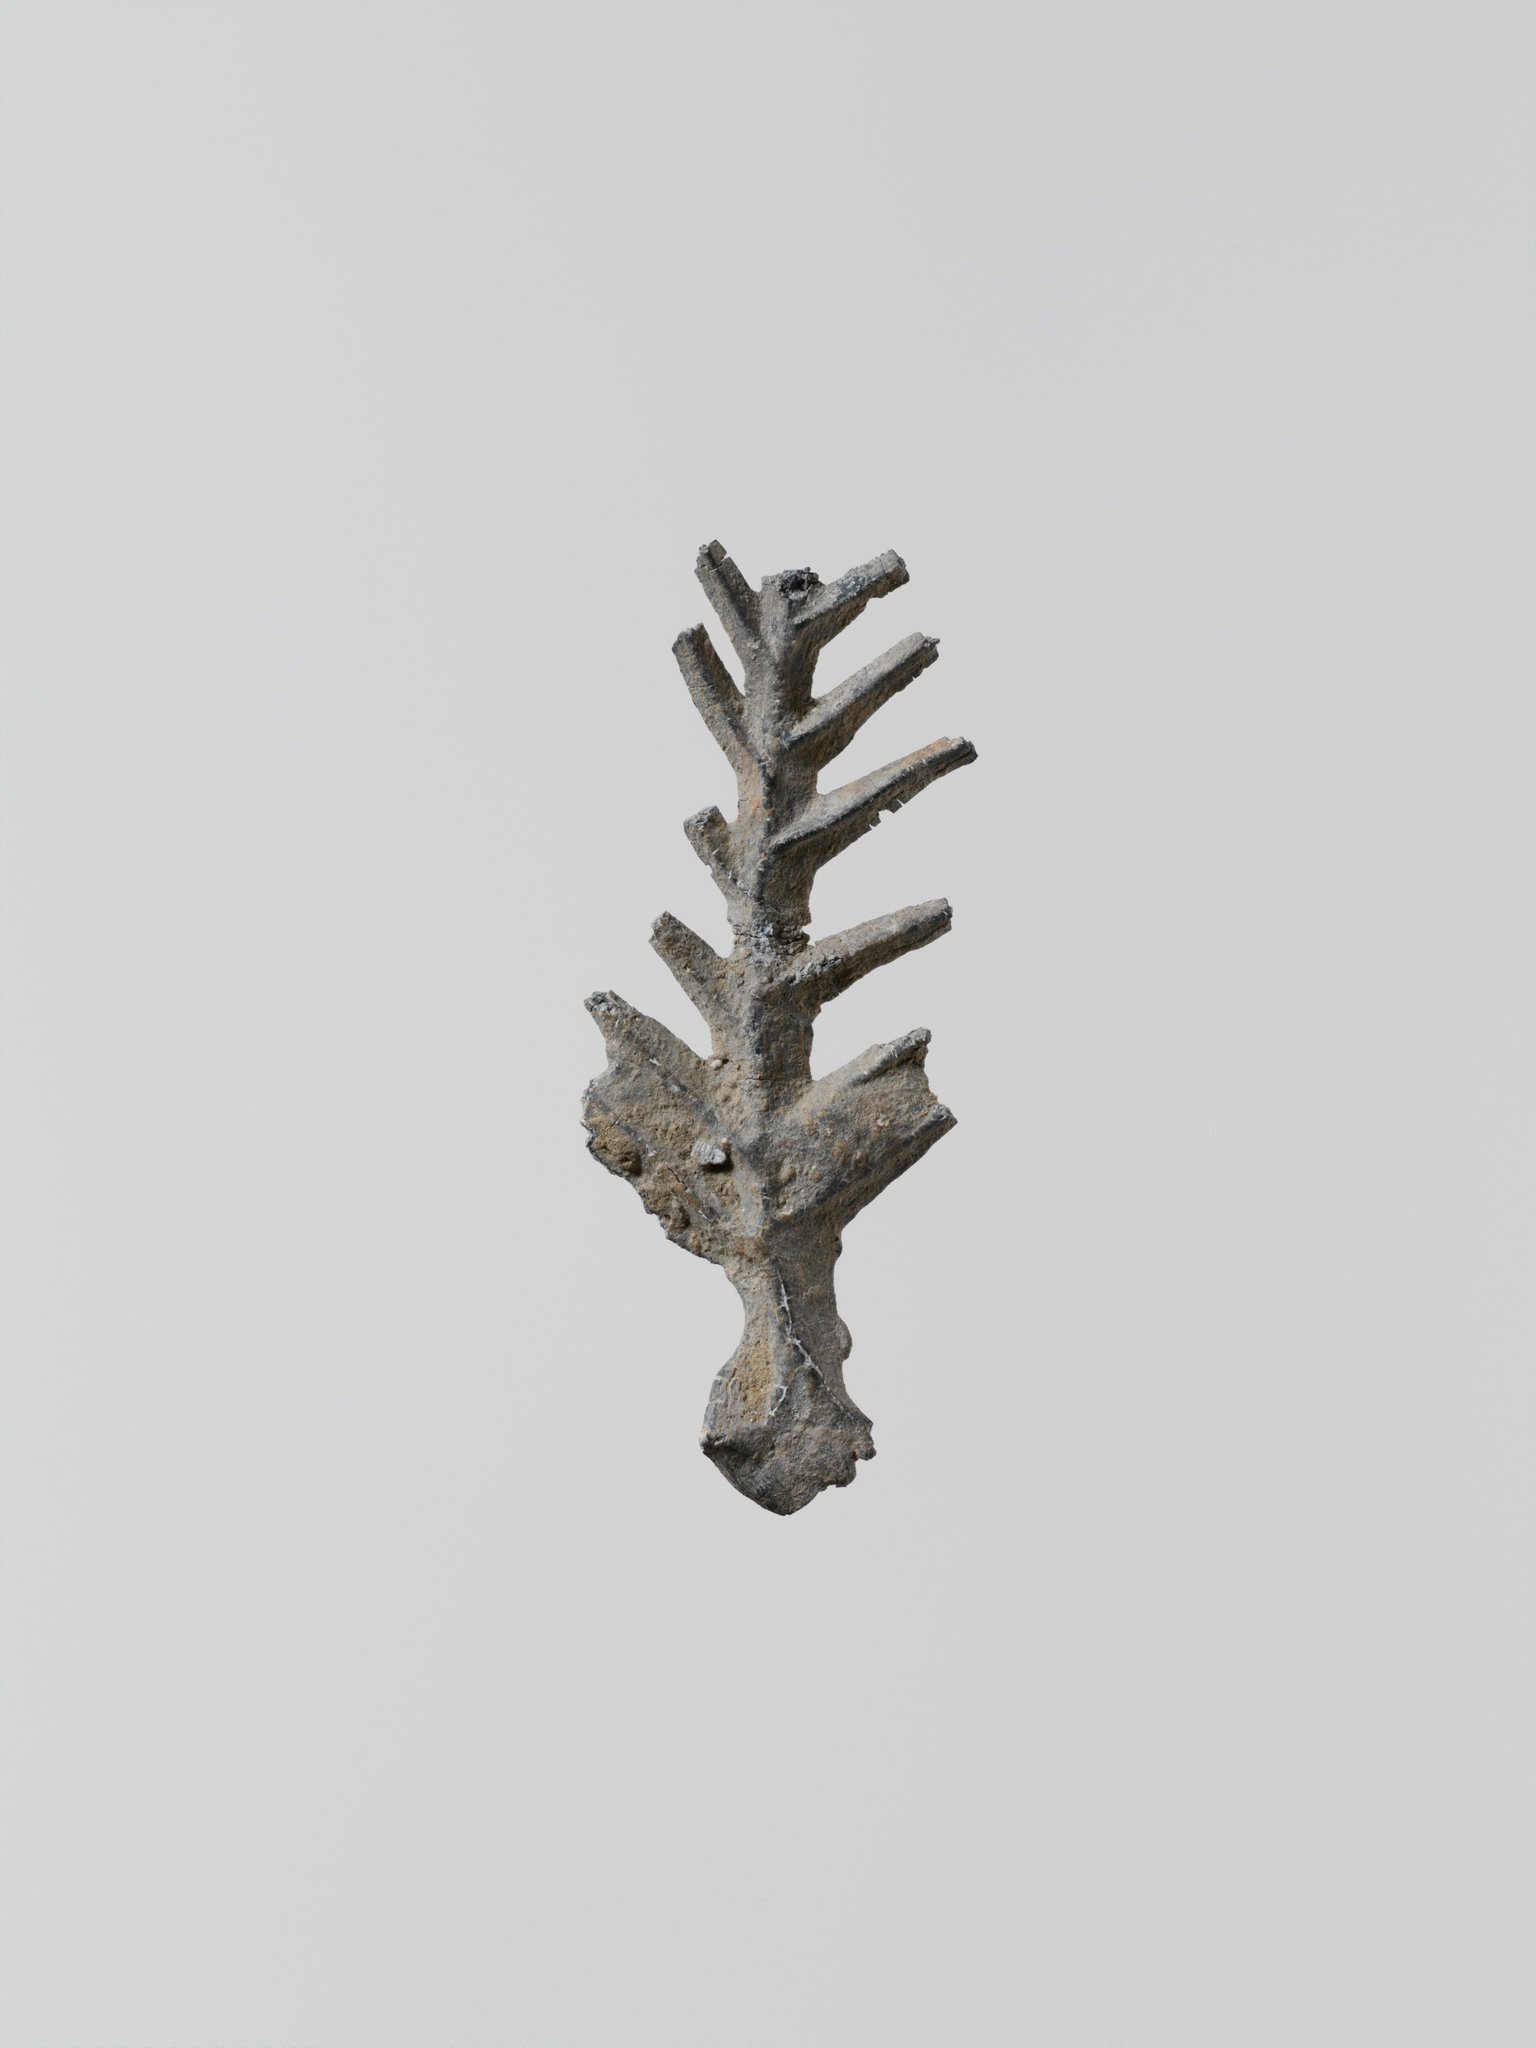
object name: ornament, 4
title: Lead ornament in the form of a branch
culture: greek, laconian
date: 600-401 BCE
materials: lead